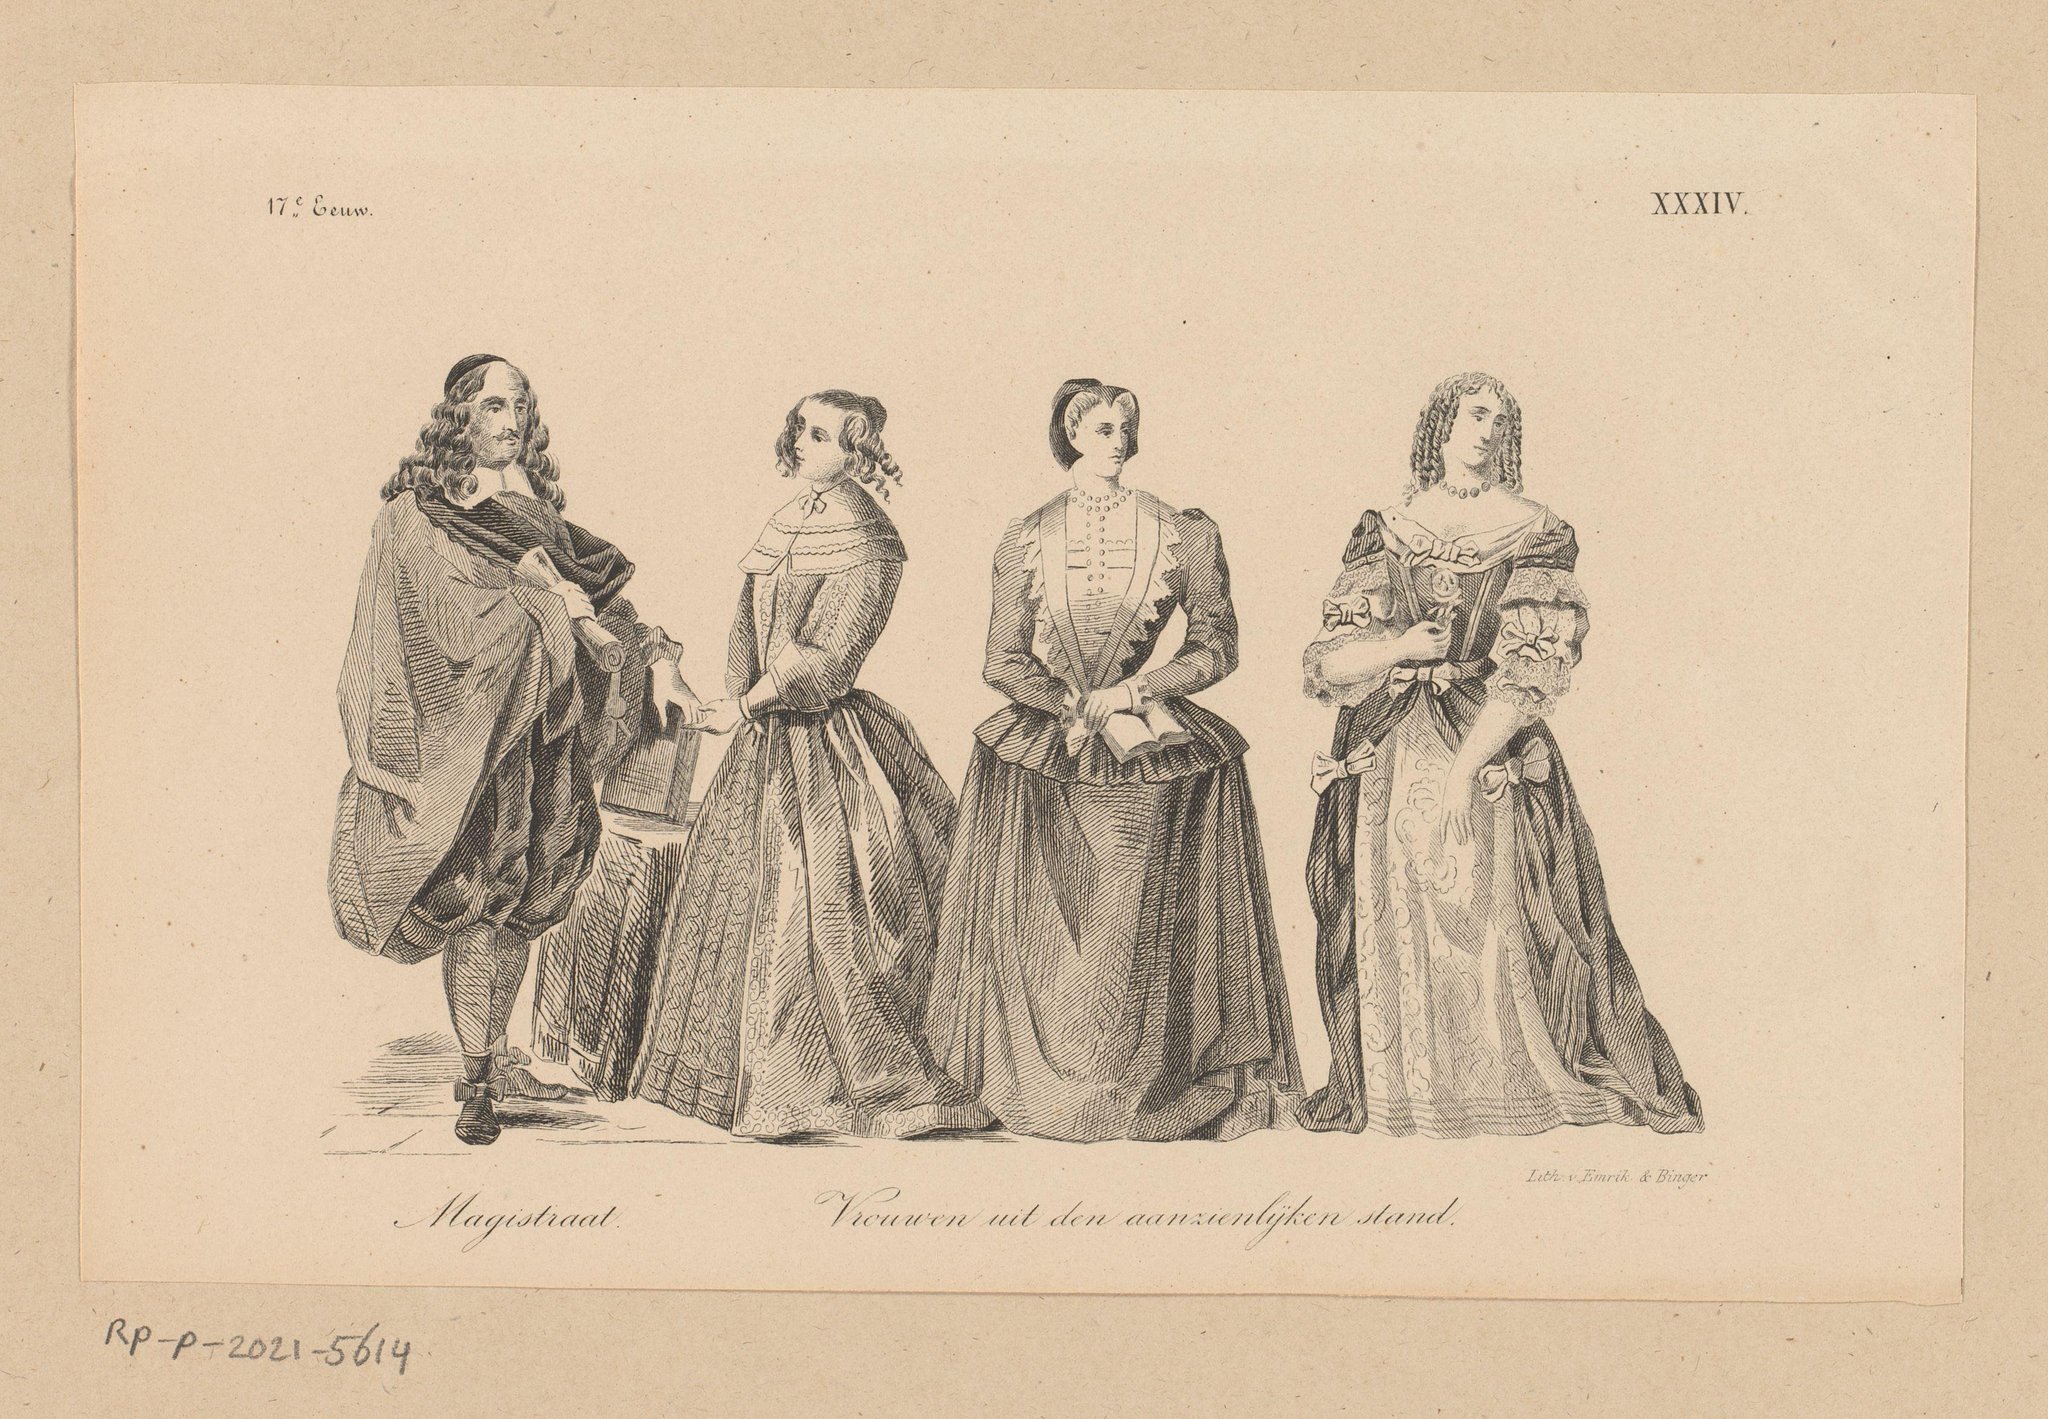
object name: book illustration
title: Magistraat en drie vrouwen in kleding uit de zeventiende eeuw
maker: Anonymous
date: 1857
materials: paper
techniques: lithograph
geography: netherlands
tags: official; civil servant; functionary (in general), flowers: rose, clothes, costume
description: Prent waarschijnlijk uit: Hofdijk, Willem Jacob. Schets van de geschiedenis der Nederlanden. Amsterdam: Gebroeders Binger, 1857.